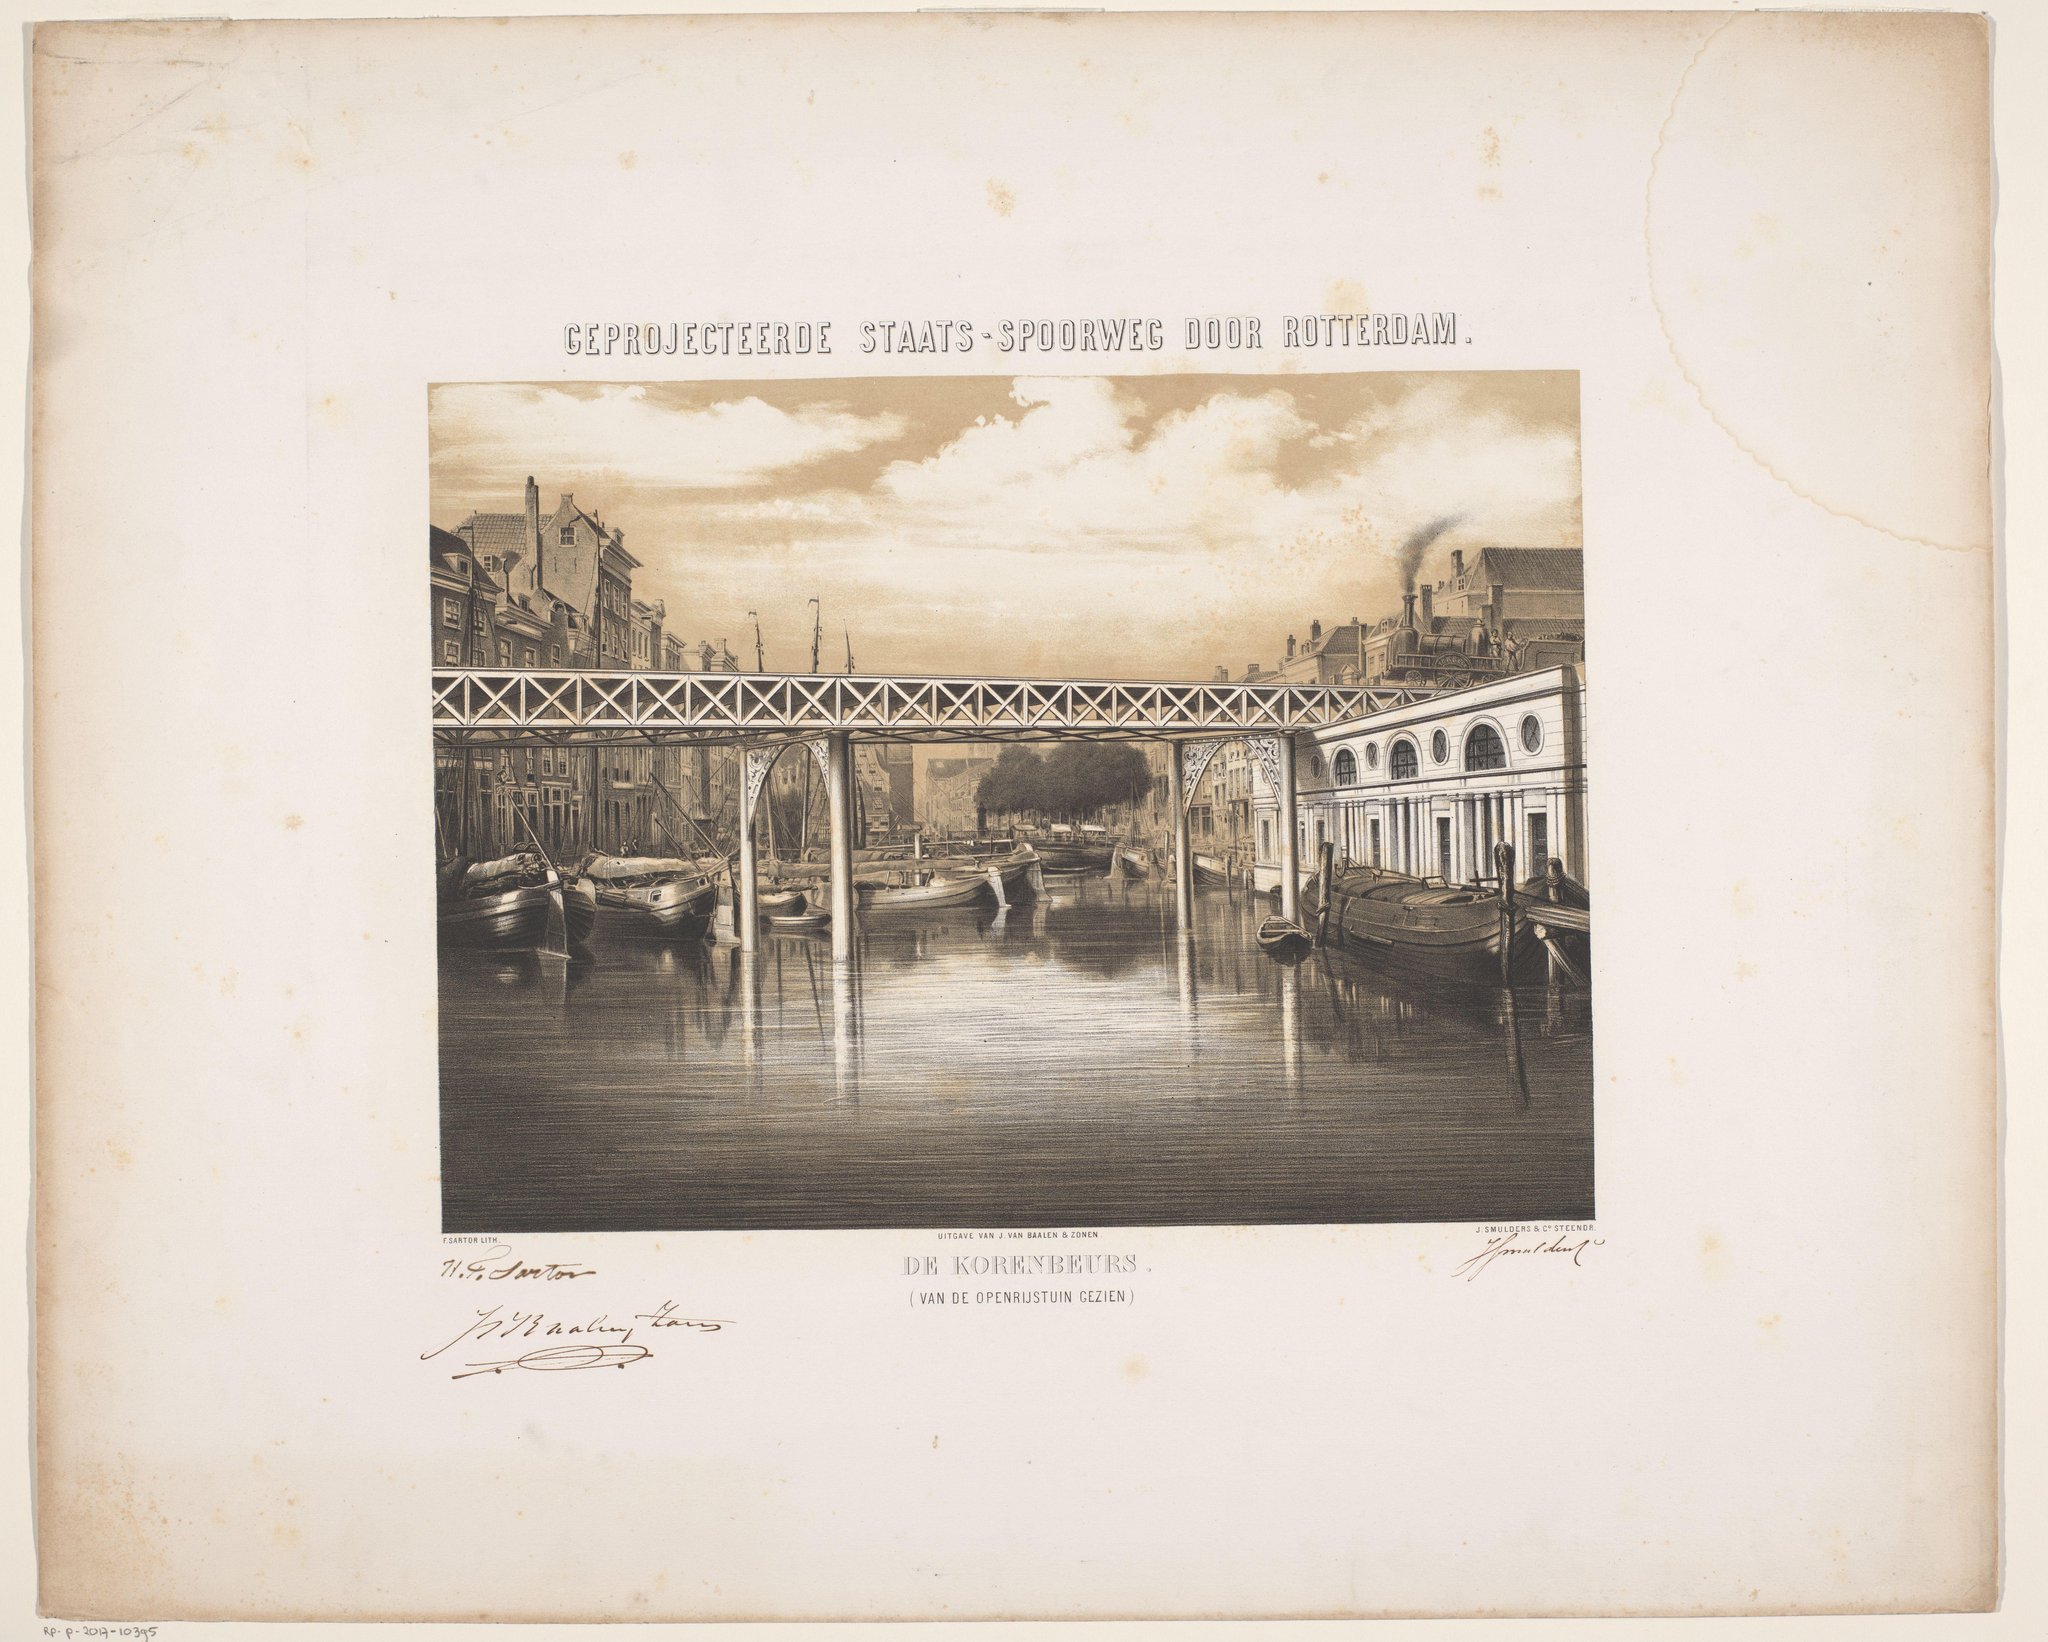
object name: print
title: Gezicht op de Korenbeurs in Rotterdam met toekomstvisie van een spoorlijn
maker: hendrik frederik sartor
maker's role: draughtsman, print maker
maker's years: 1818-1881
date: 1864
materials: paper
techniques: tone lithography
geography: the hague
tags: rotterdam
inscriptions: : ‘F. Sartor J. Smulders & Co / J. van Baalen en zonen’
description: De spoorlijn loopt over de Korenbeurs en het water. Maakt deel uit van een serie van zeven prenten.